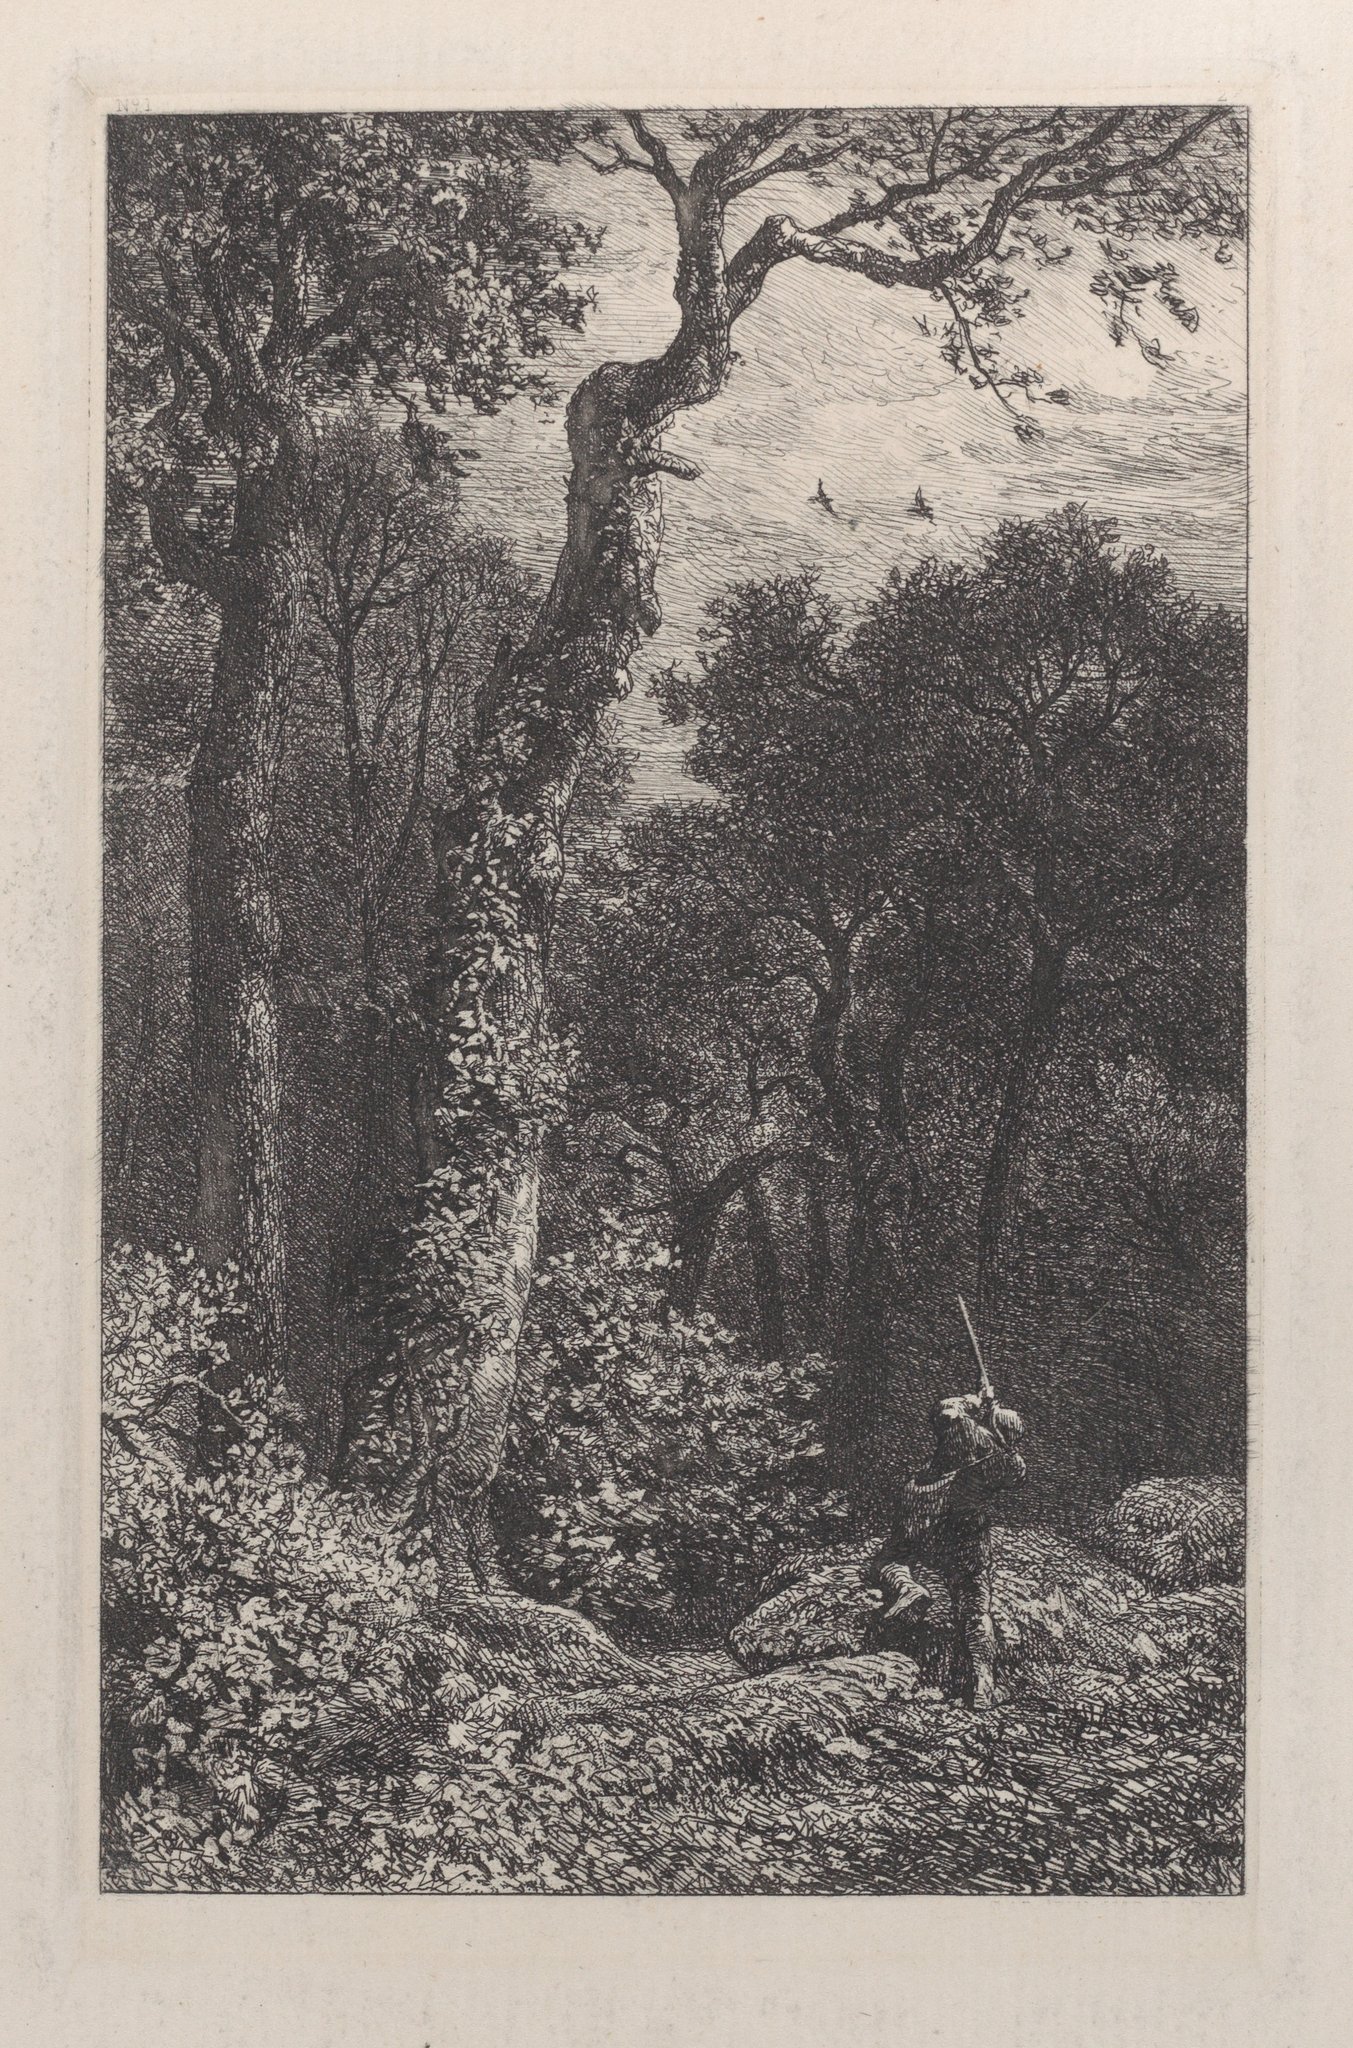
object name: print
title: Shooting a Woodcock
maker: charles émile jacque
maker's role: artist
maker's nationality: french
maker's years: 1813-1894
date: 1864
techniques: etching